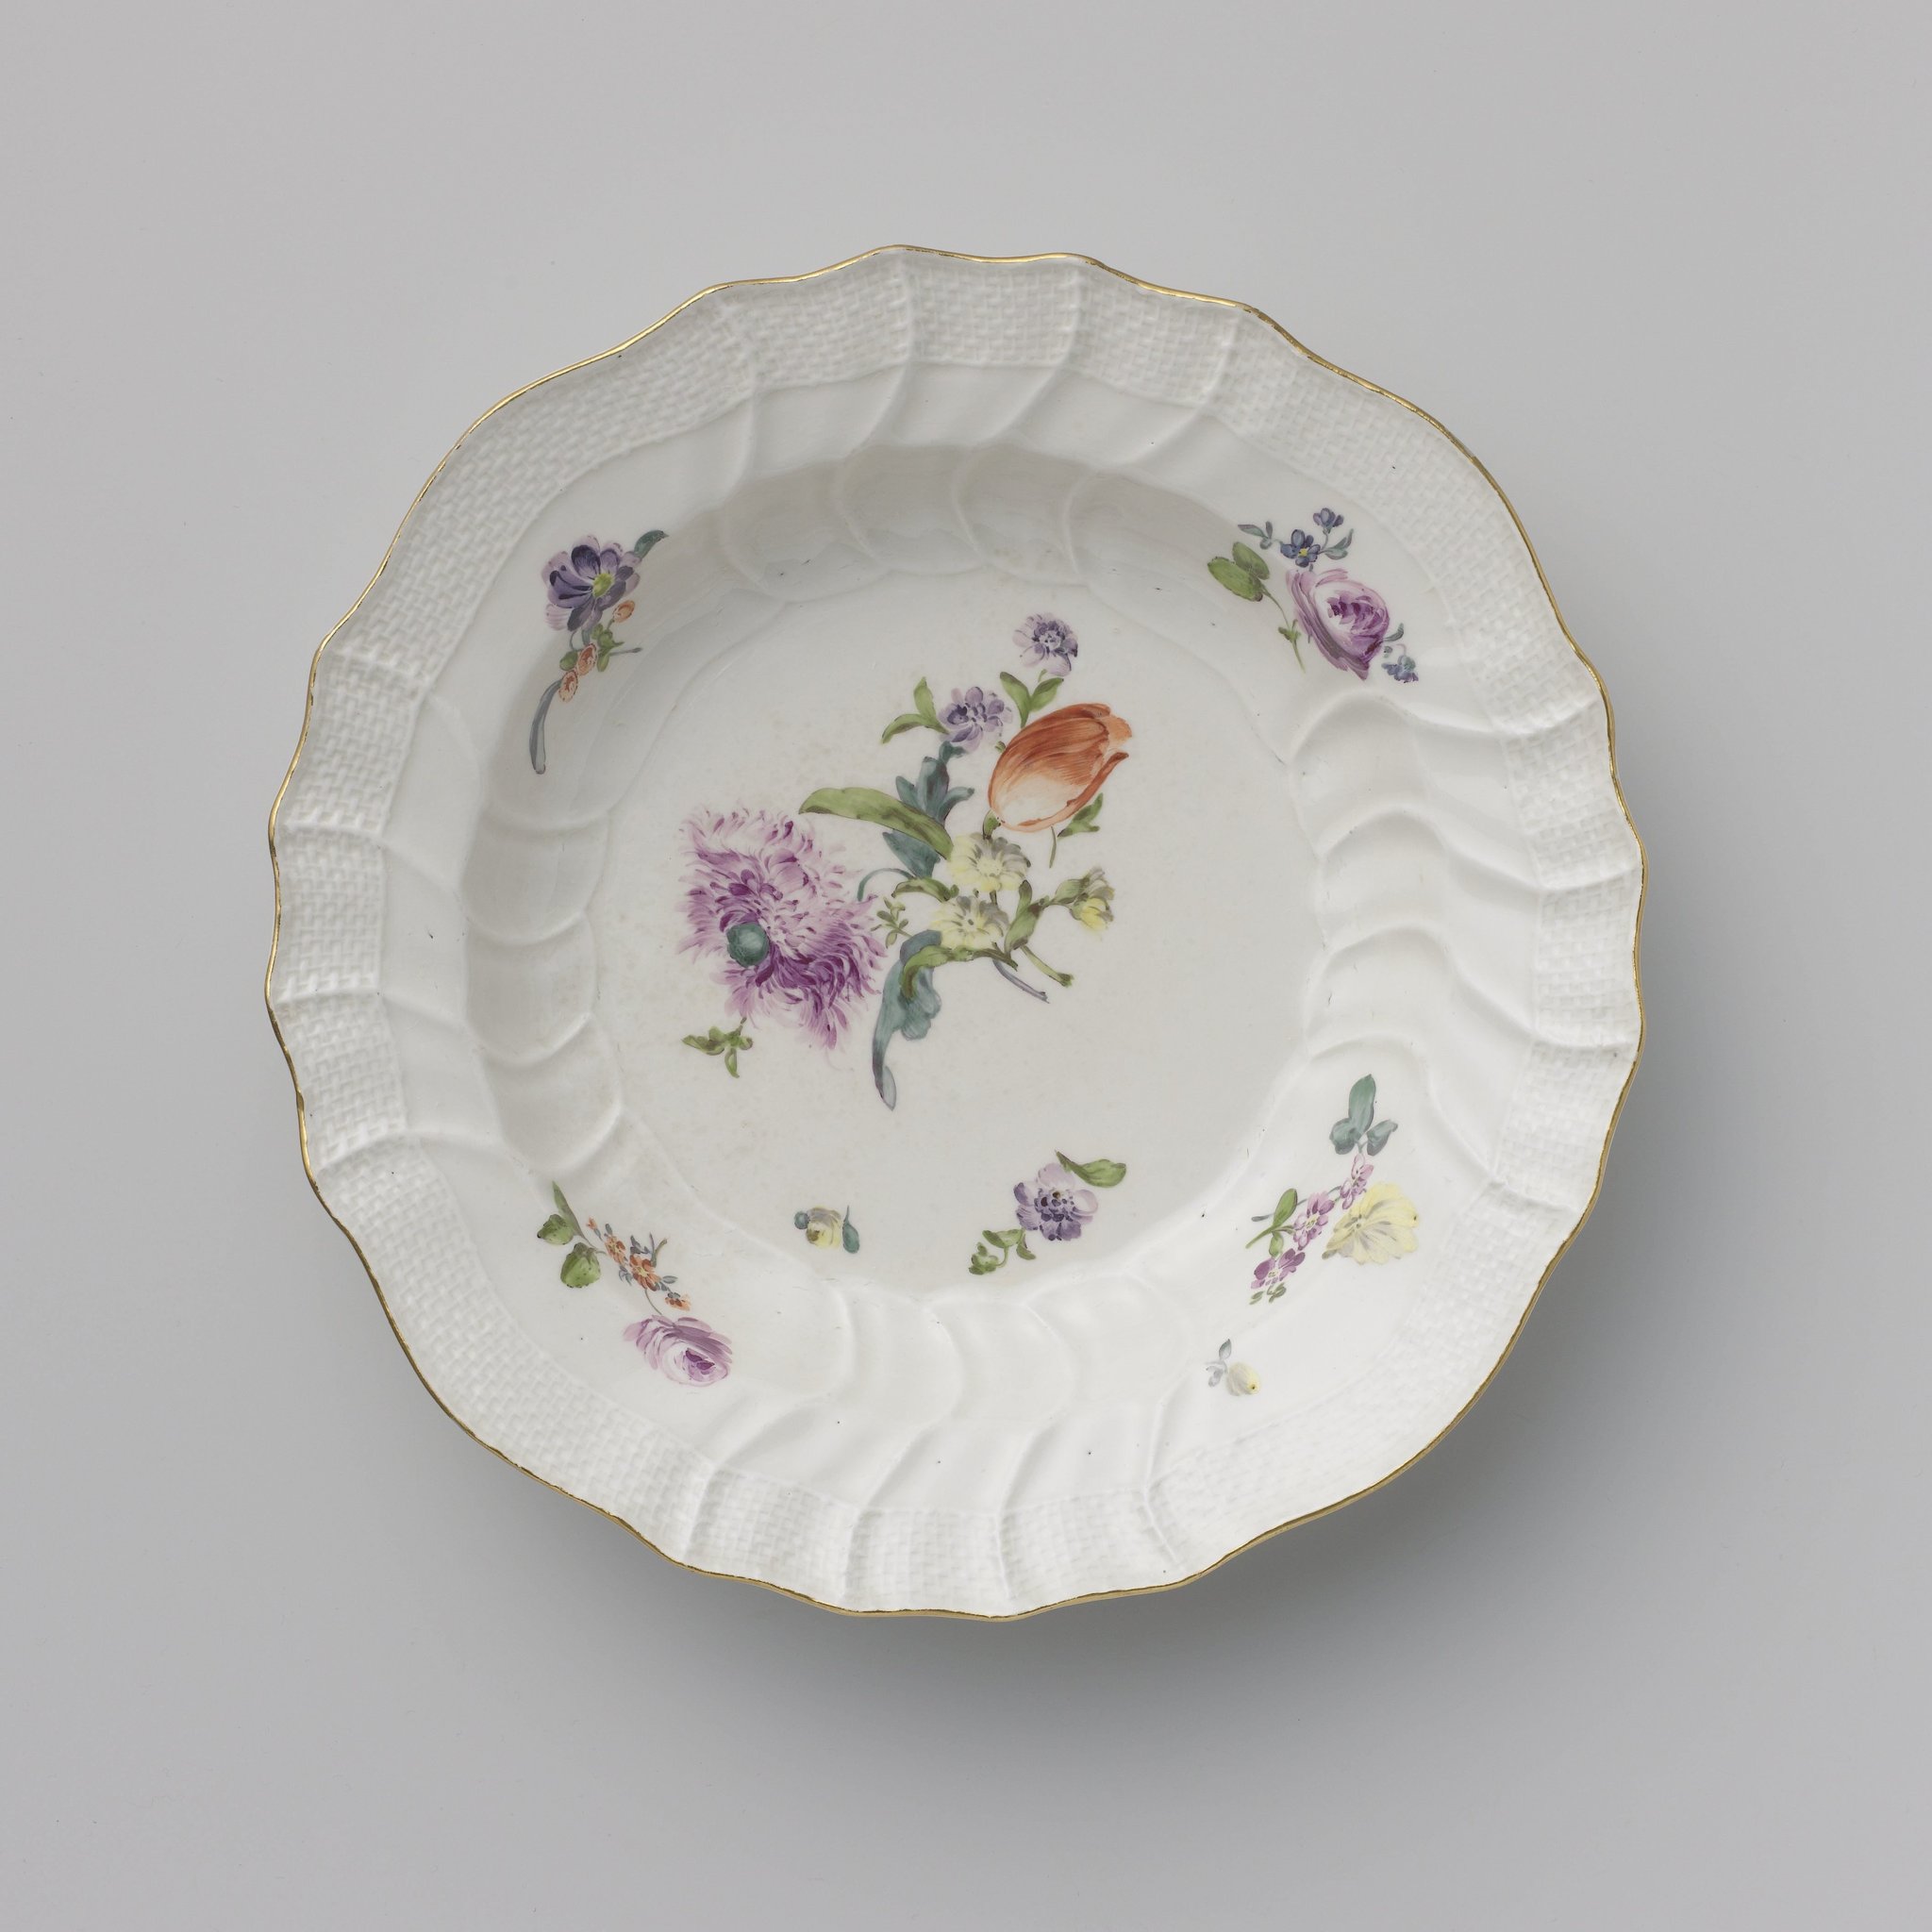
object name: soup plate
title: Bord, veelkleurig beschilderd met Deutsche Blumen, insekten en vruchten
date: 1750-1760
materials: porcelain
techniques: painted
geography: meissen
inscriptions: factory mark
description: Rond soepbord van beschilderd porselein. Het bord is beschilderd met Deutsche Blumen, insekten en vruchten. De rand is in reliëf versierd met het Neuozier-patroon. Het bord is gemerkt en hoort bij een servies (BK-17474-1 t/m BK-17474-253).